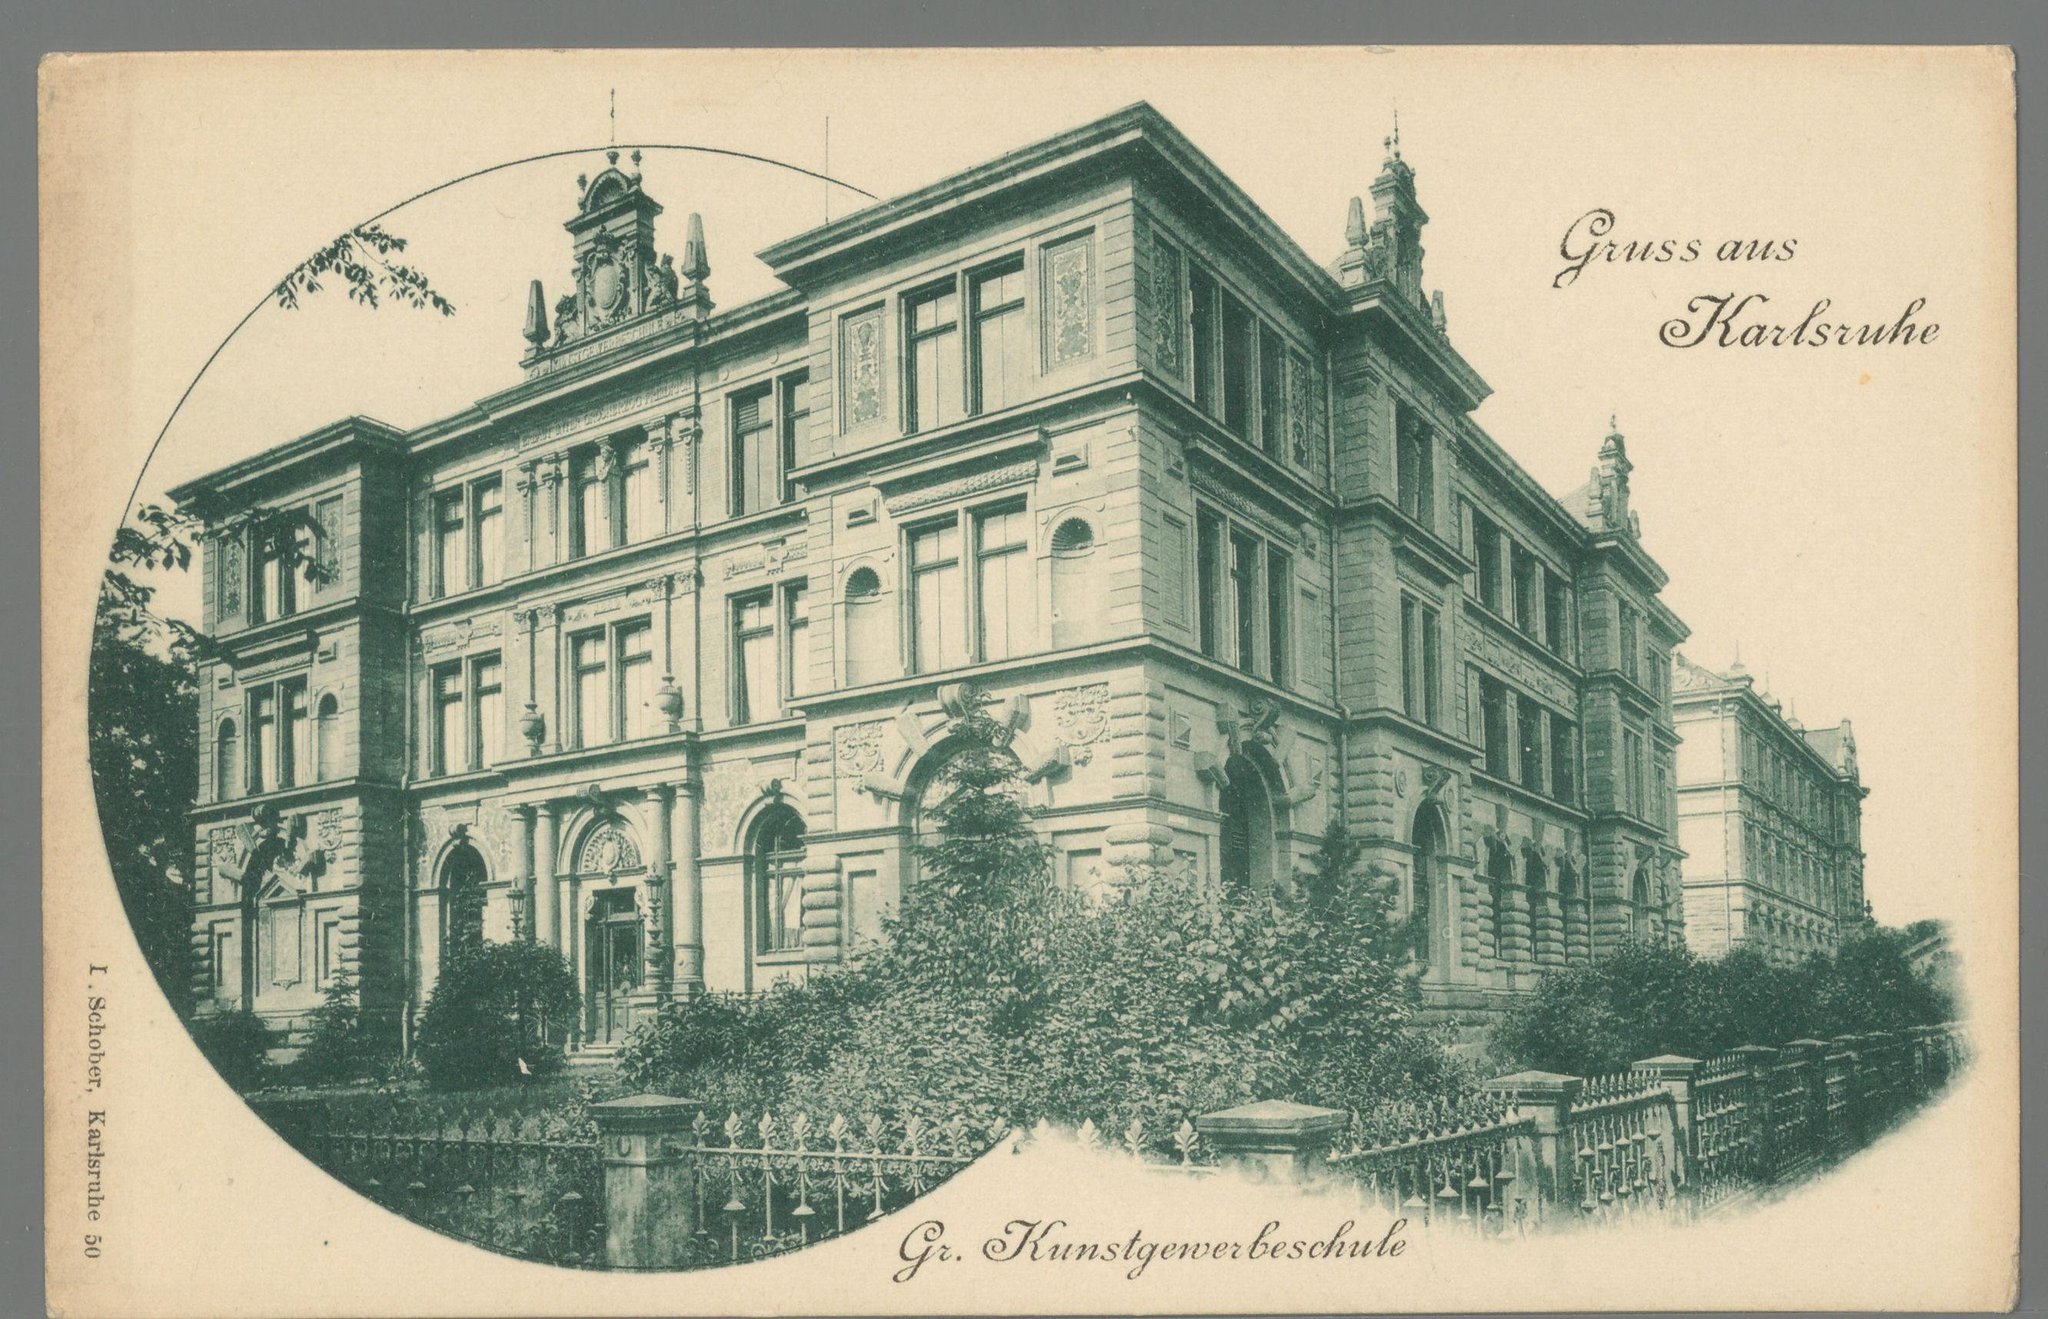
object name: photomechanical print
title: Gruss aus Karlsruhe. Gr. Kunstgewerbeschule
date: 1885-1905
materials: cardboard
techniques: photograph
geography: karlsruhe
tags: university building, college